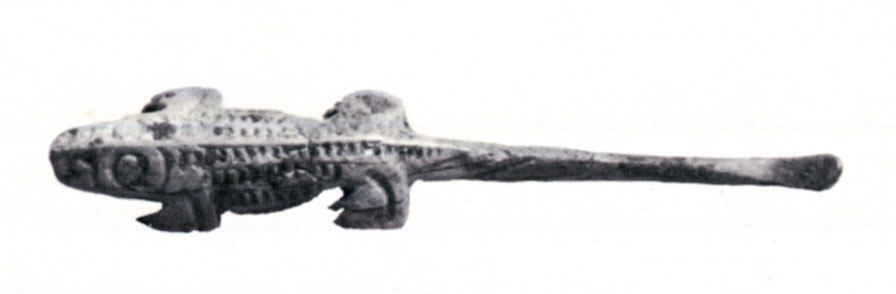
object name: ear pick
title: Ear Pick in the Shape of an Alligator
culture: chinese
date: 1300-1001 BCE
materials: bone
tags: crocodiles